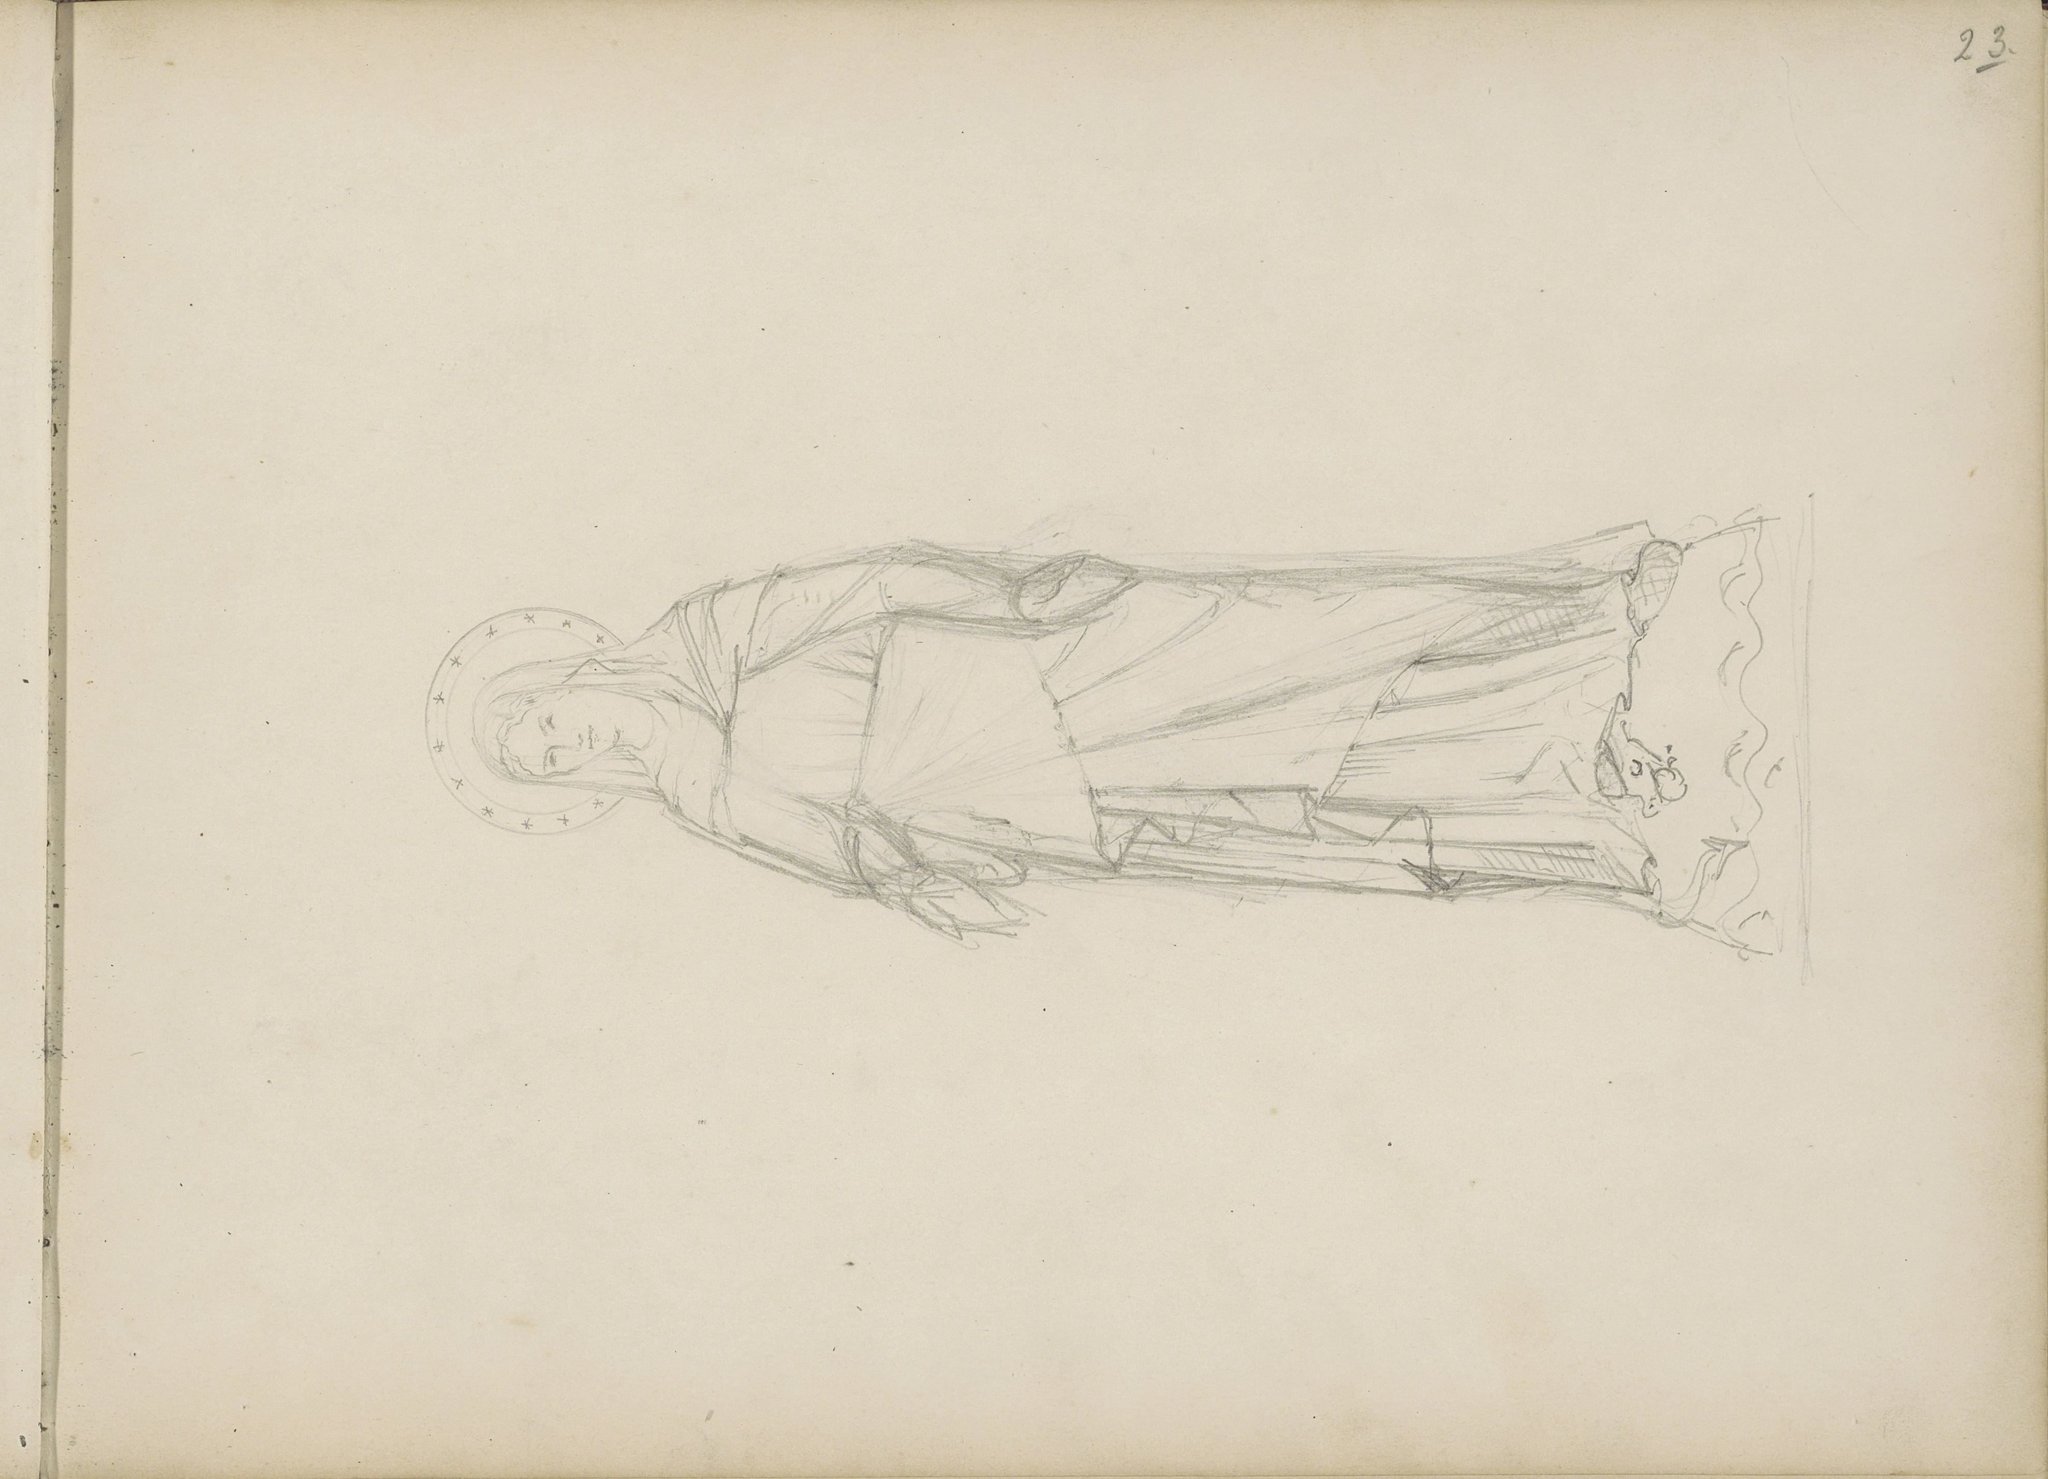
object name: sketchbook leaf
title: Sculptuur van Maria Onbevlekt Ontvangen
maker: pierre joseph hubert cuypers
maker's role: draughtsman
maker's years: 1827-1921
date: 1858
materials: paper, pencil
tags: the church symbolized (+ mary)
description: Maria gekleed in een mantel met een sluier over het hoofd, staande op een wereldbol met onder haar voet de kop van een slang met appel in de bek. Blad 23 recto uit een schetsboek met 77 bladen.